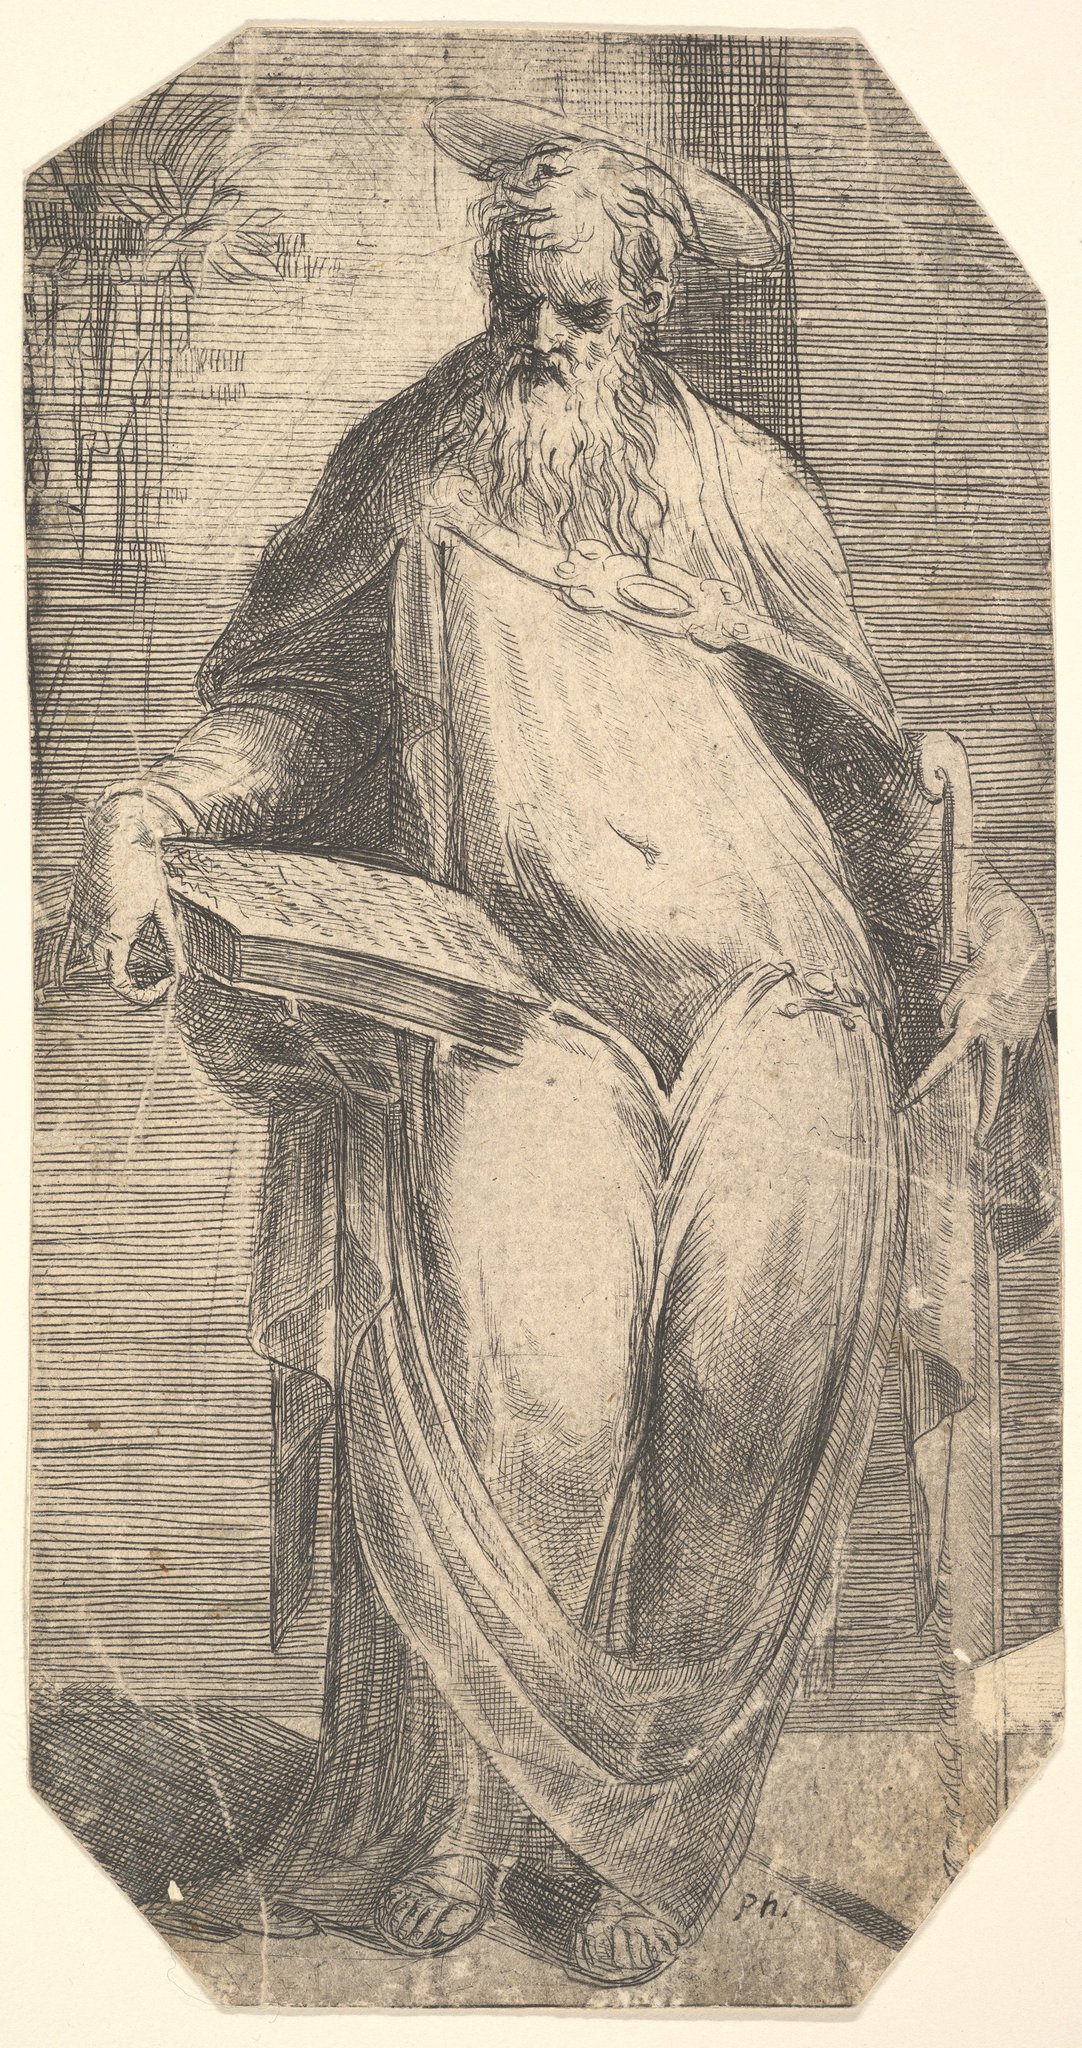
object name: print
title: Saint Simon standing, supporting a book on his right thigh, from "Christ and the Apostles"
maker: andrea schiavone (andrea meldola)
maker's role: artist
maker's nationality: italian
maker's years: 1510-1563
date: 1548-1550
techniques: etching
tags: books,saints